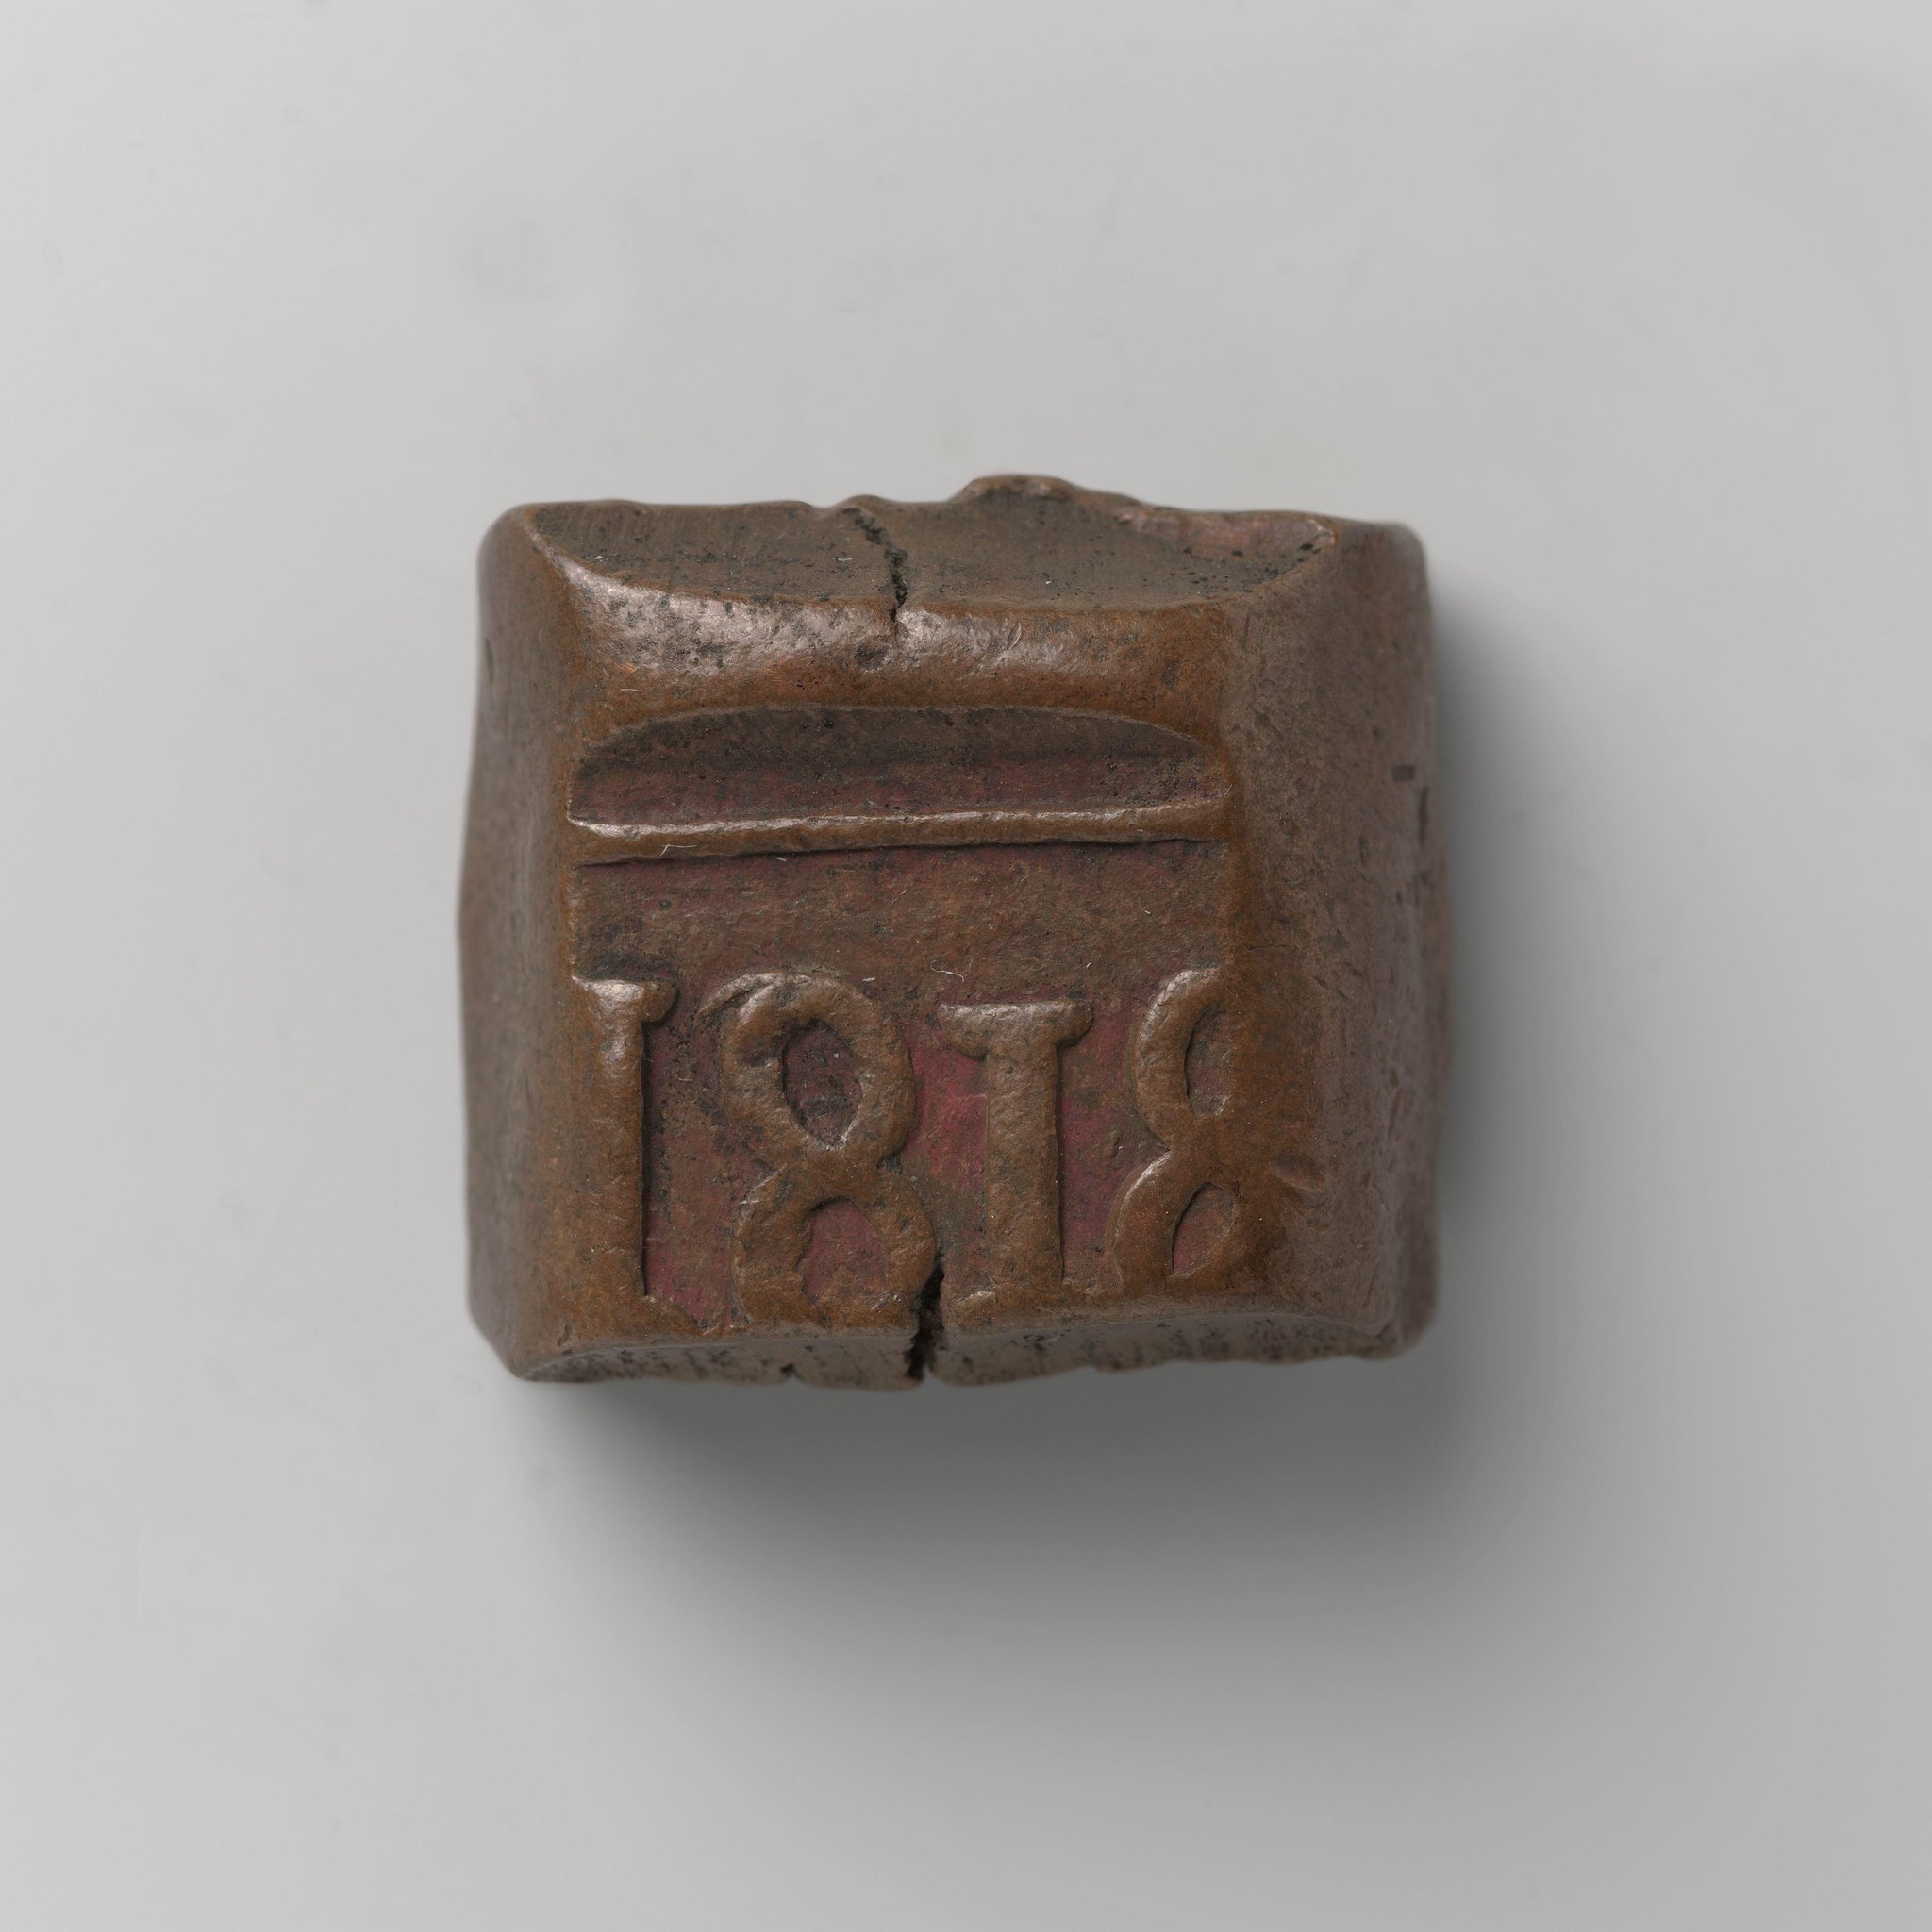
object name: coin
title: Bonk van 2 stuivers van Nederlands Indië,1818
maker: william i of the netherlands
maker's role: koning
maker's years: 1772-1843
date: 1818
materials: copper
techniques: striking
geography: surabaya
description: Koperen rechthoekige munt. Voorzijde: binnen een rechthoekige lijst waarde-aanduiding 2 St. Keerzijde: binnen een rechthoekige lijst jaartal.